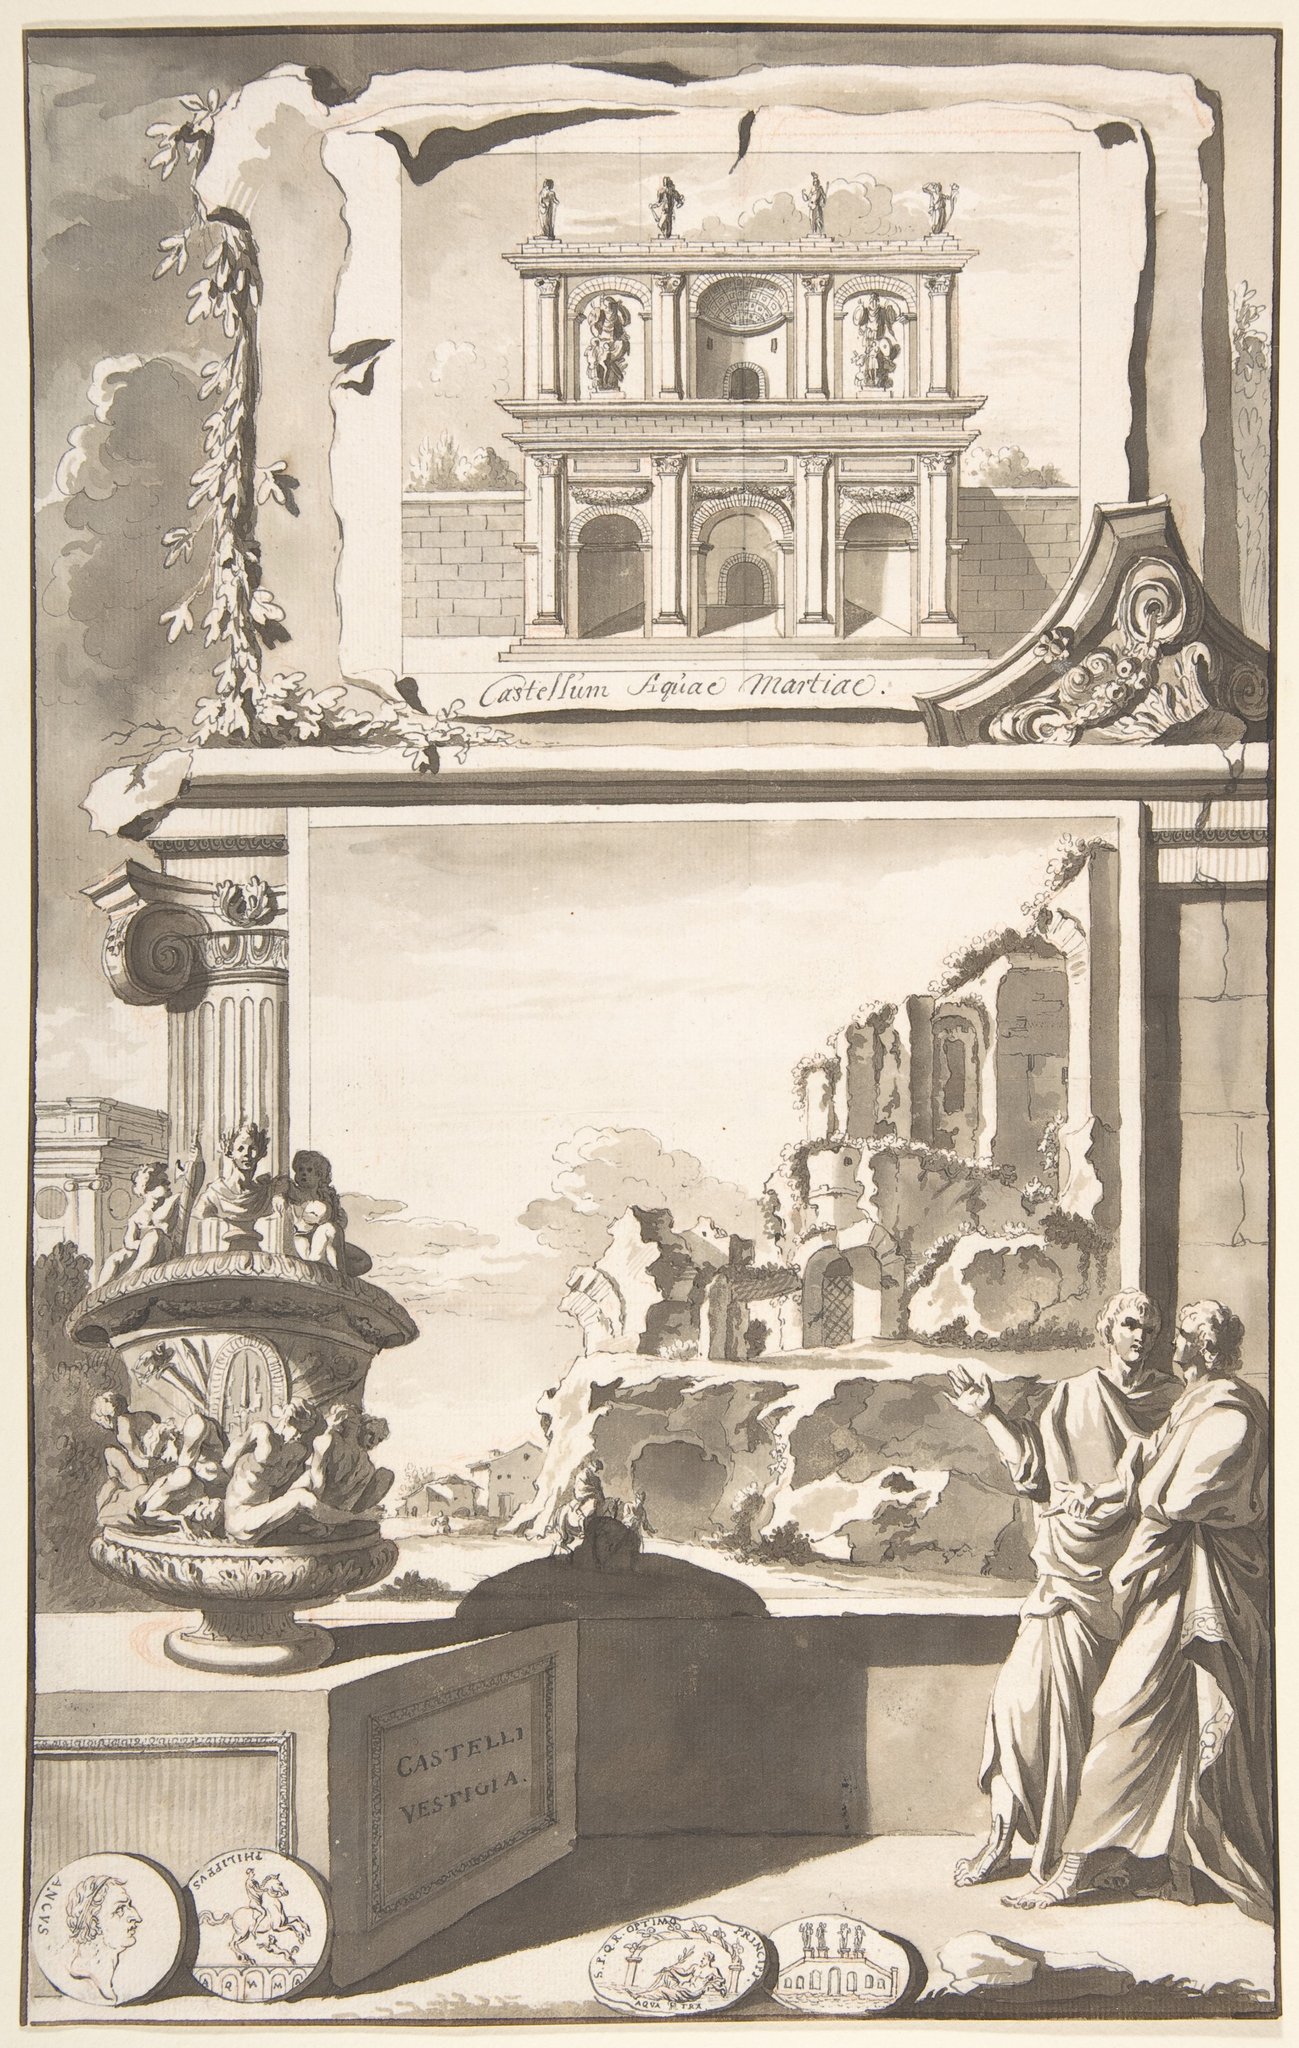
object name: drawing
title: A Reconstruction of the Castellum Aquiae Martiae (above) and a View of the Ruins (below)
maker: jan goeree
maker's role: artist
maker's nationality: dutch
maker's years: 1670-1731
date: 1704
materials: chalk, ink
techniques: brush, pen, wash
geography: italy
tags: buildings,ruins,men